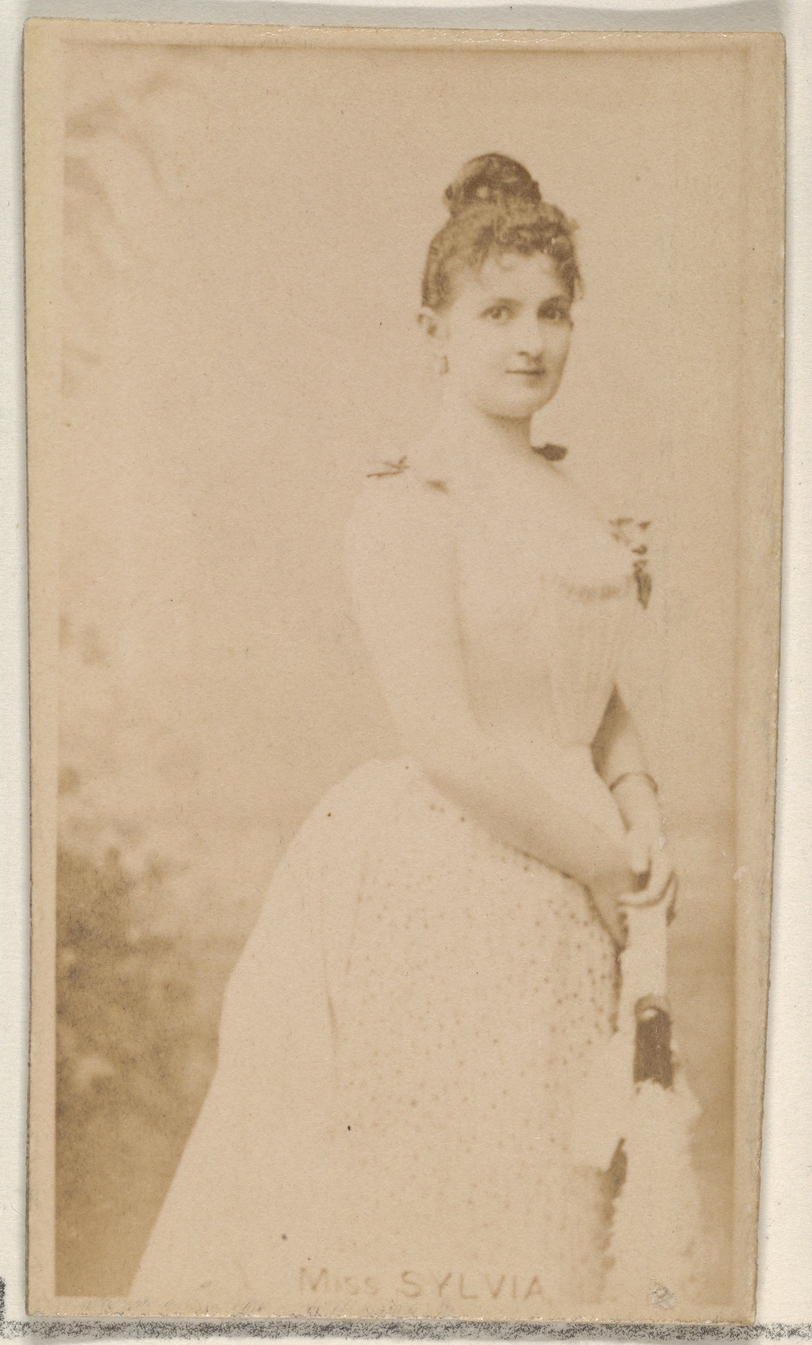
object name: photograph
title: Miss Sylvia, from the Actors and Actresses series (N45, Type 8) for Virginia Brights Cigarettes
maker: allen & ginter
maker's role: publisher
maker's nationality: american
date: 1888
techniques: albumen silver print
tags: portraits,women,actresses